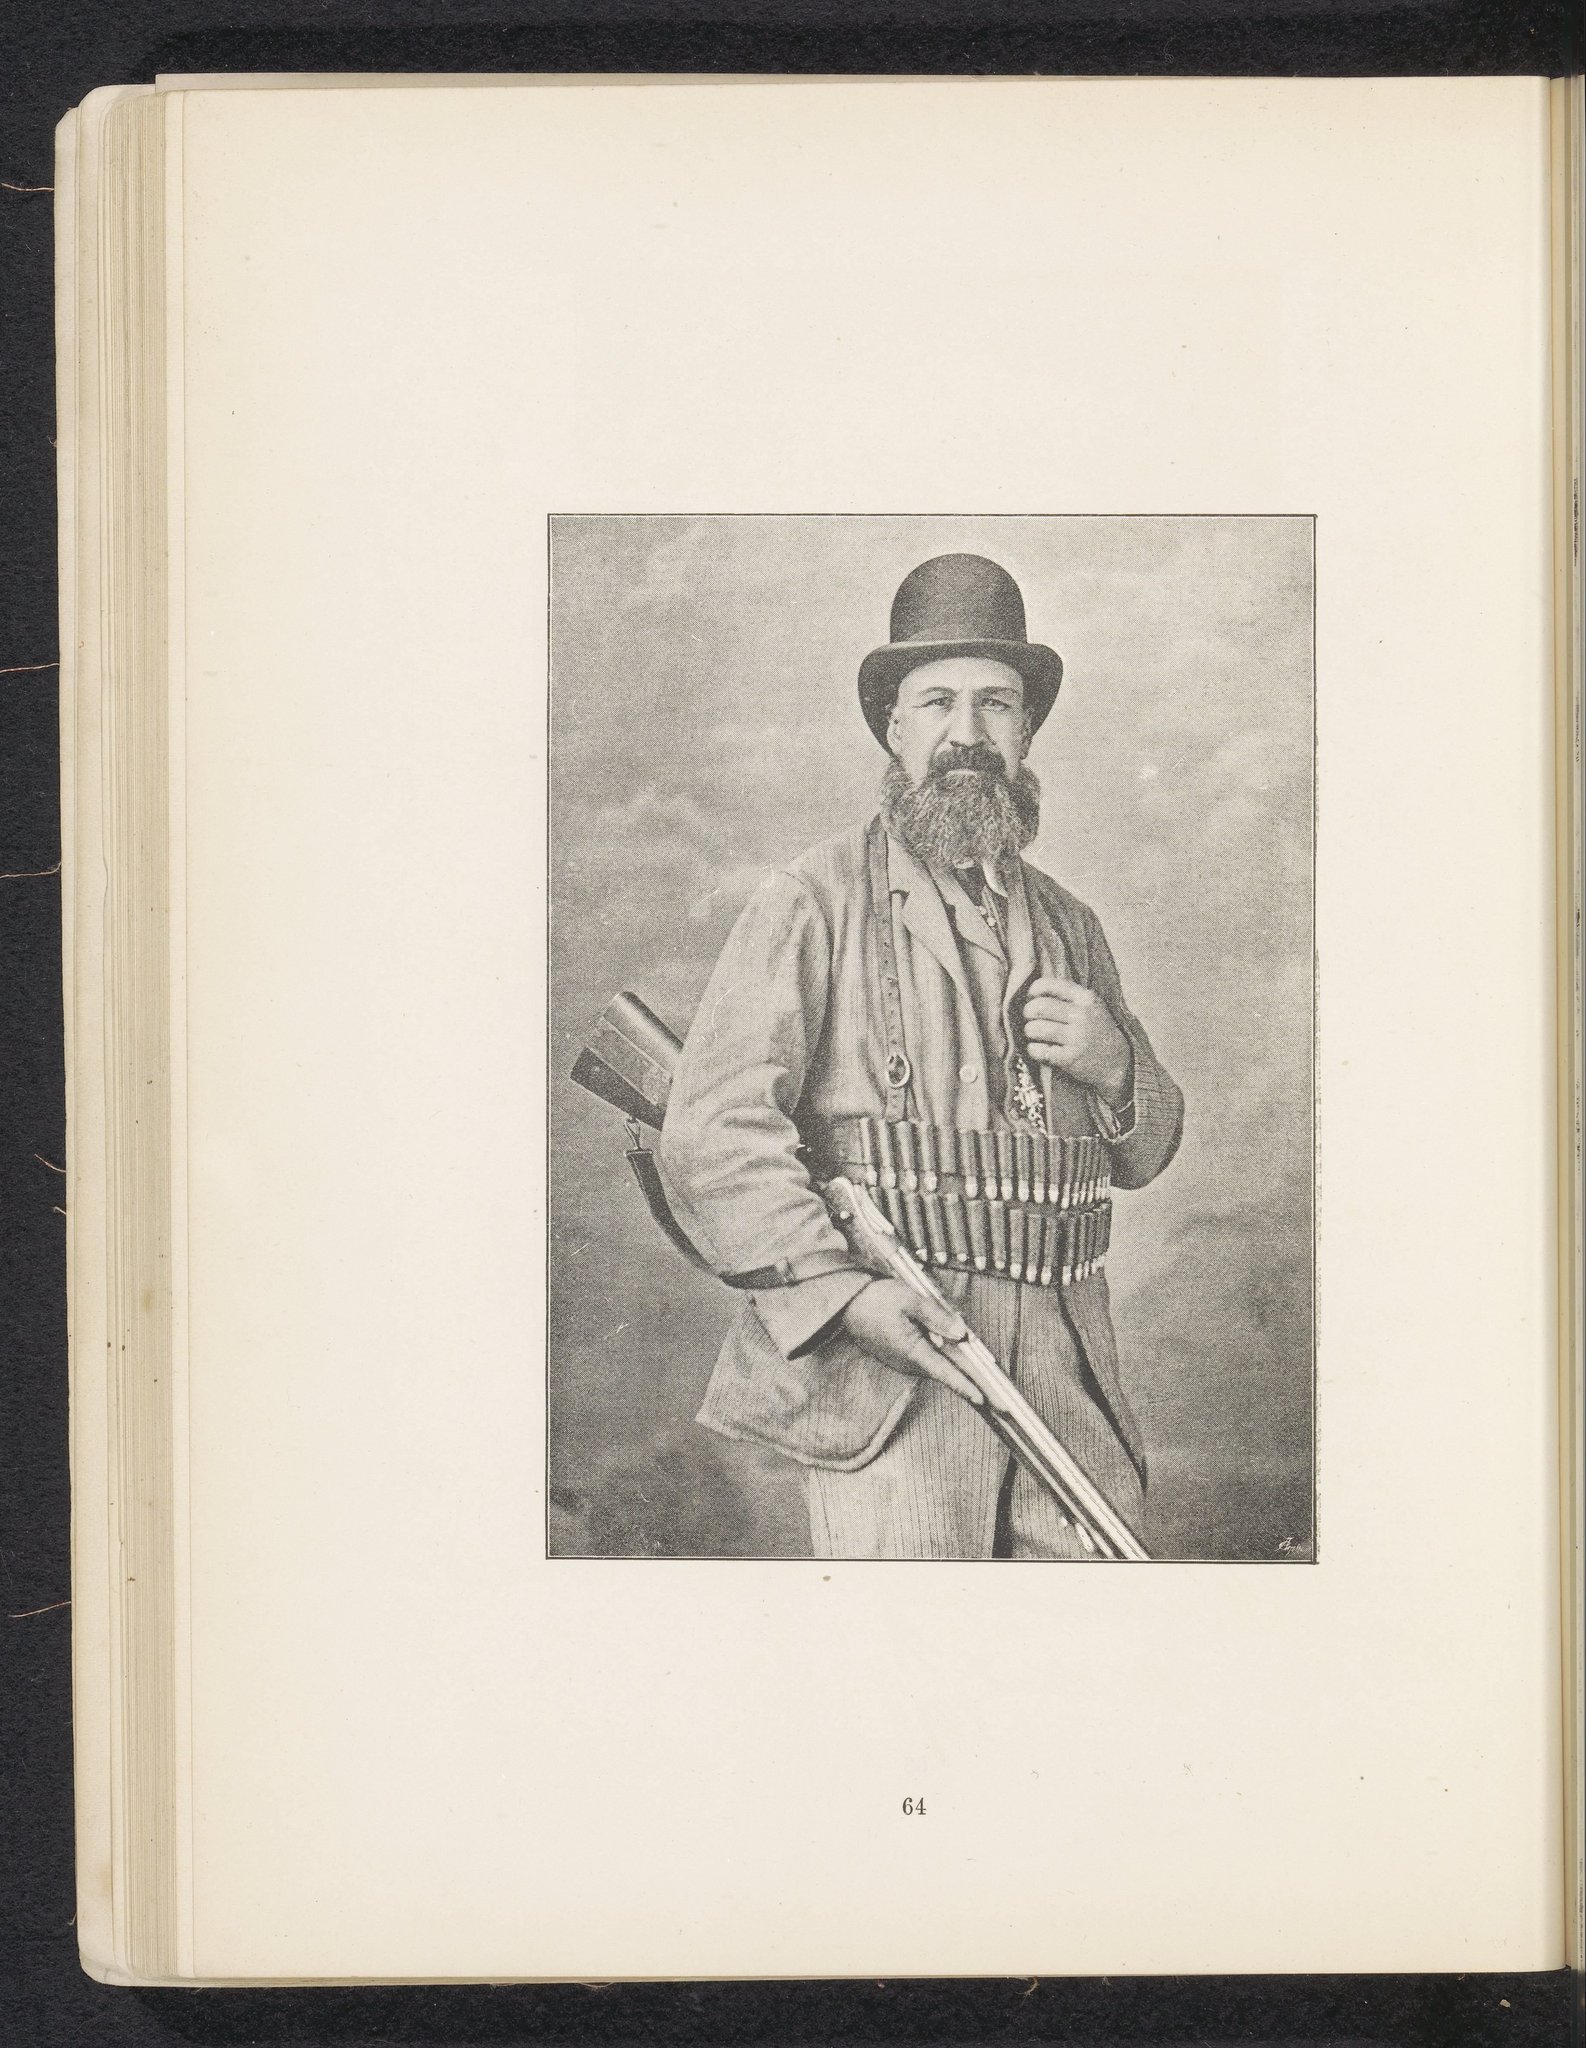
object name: page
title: Portret van Petrus Jacobus Joubert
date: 1881-1891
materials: paper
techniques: autotype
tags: politician, commander-in-chief, general, marshal